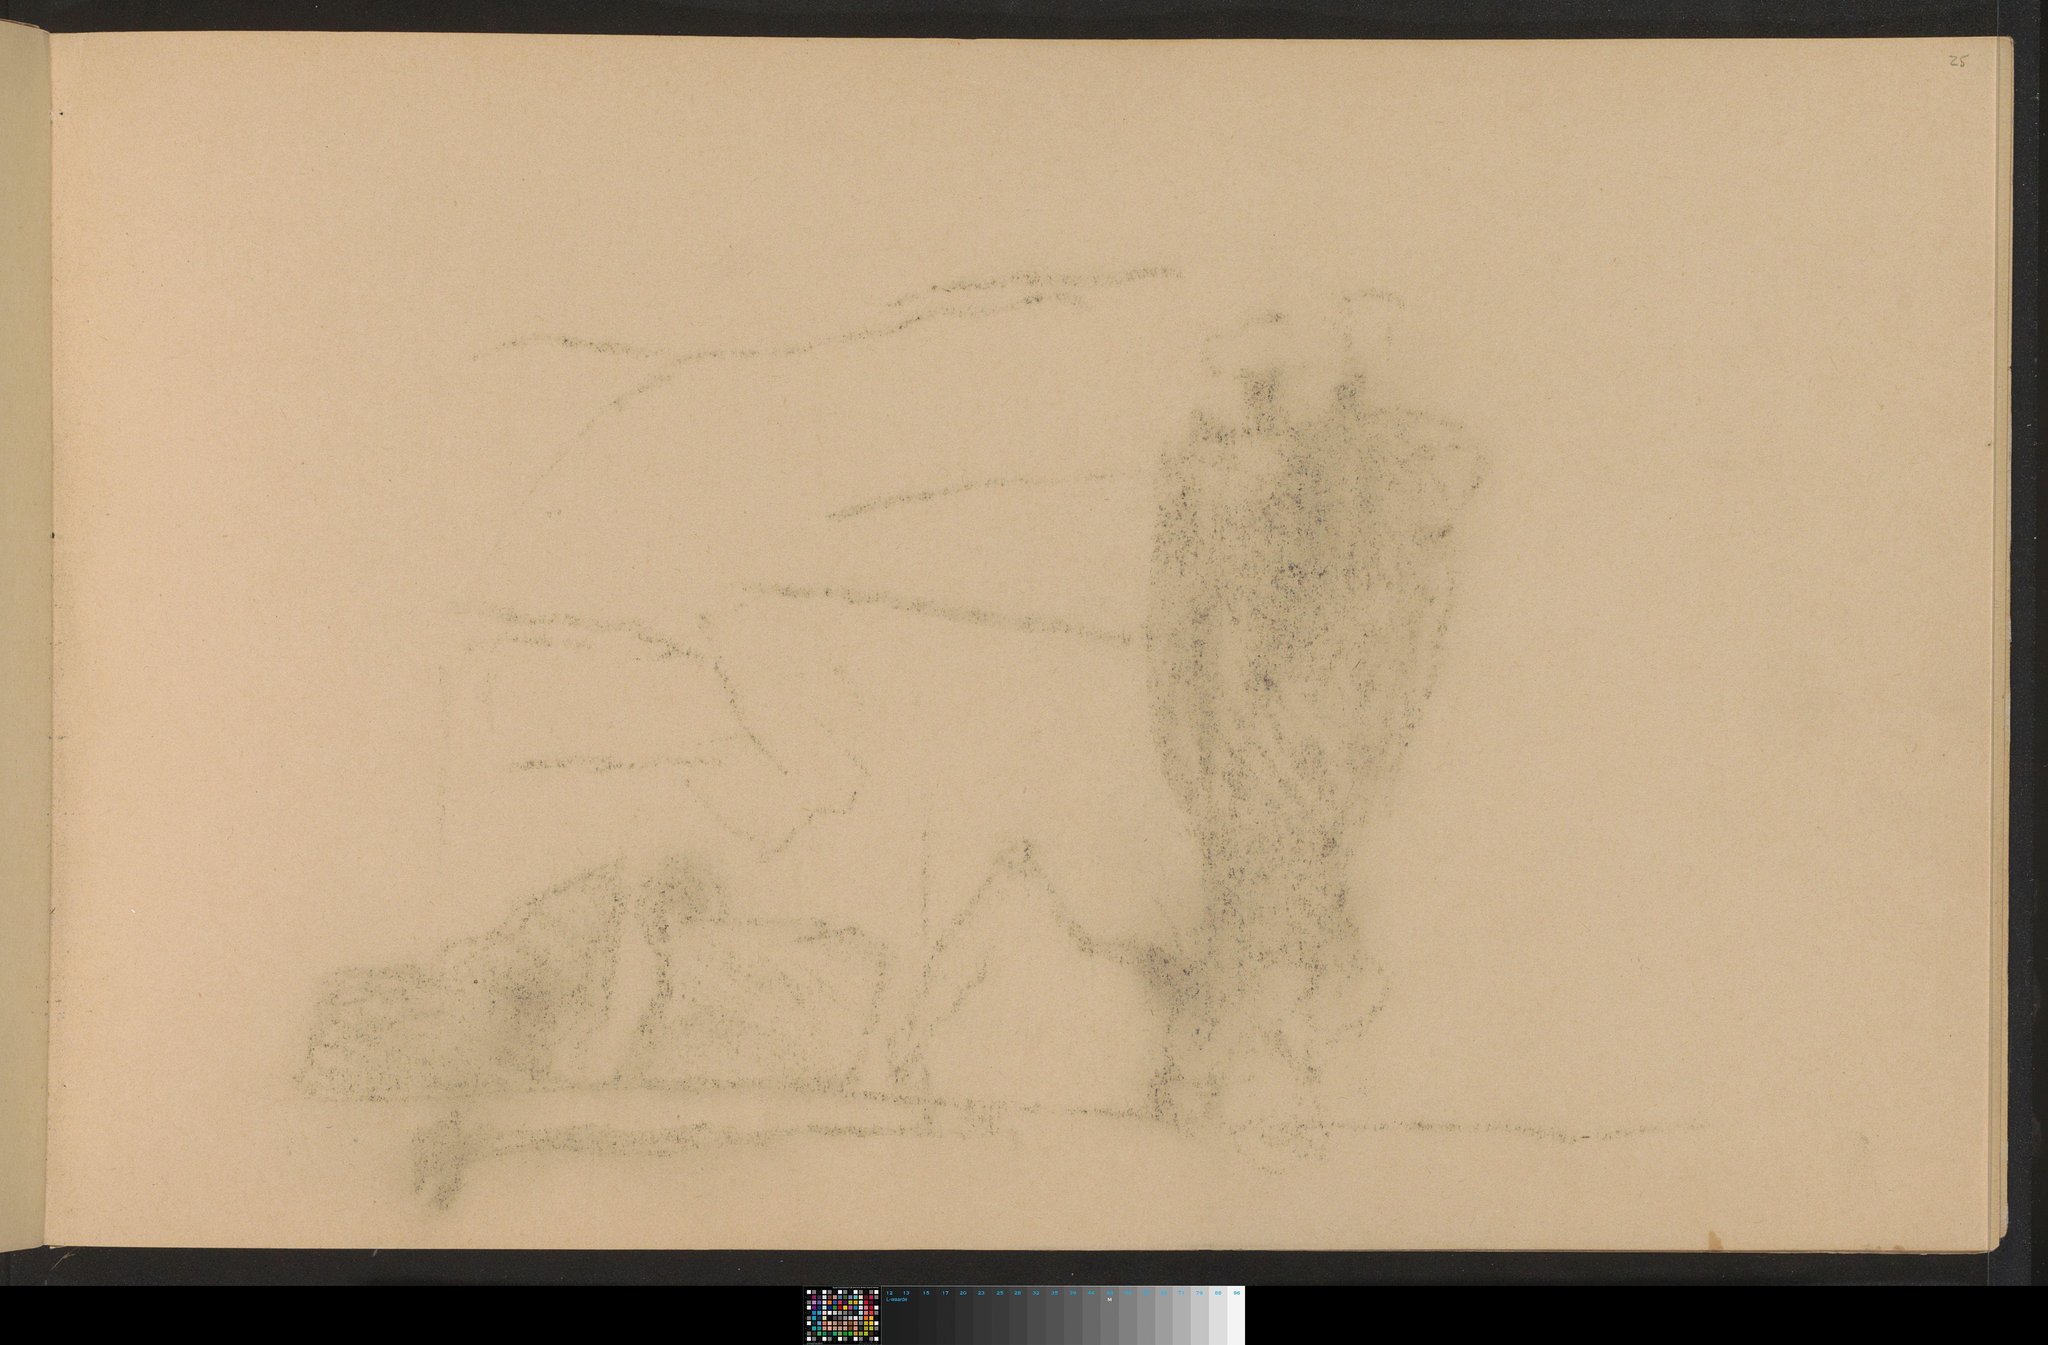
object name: sketchbook leaf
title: Abklatsch van de krijttekening op pagina 24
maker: willem witsen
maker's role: draughtsman, painter, print maker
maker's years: 1860-1923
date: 1897-1910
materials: paper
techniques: printmaking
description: Pagina 25 uit een schetsboek met 19 bladen.